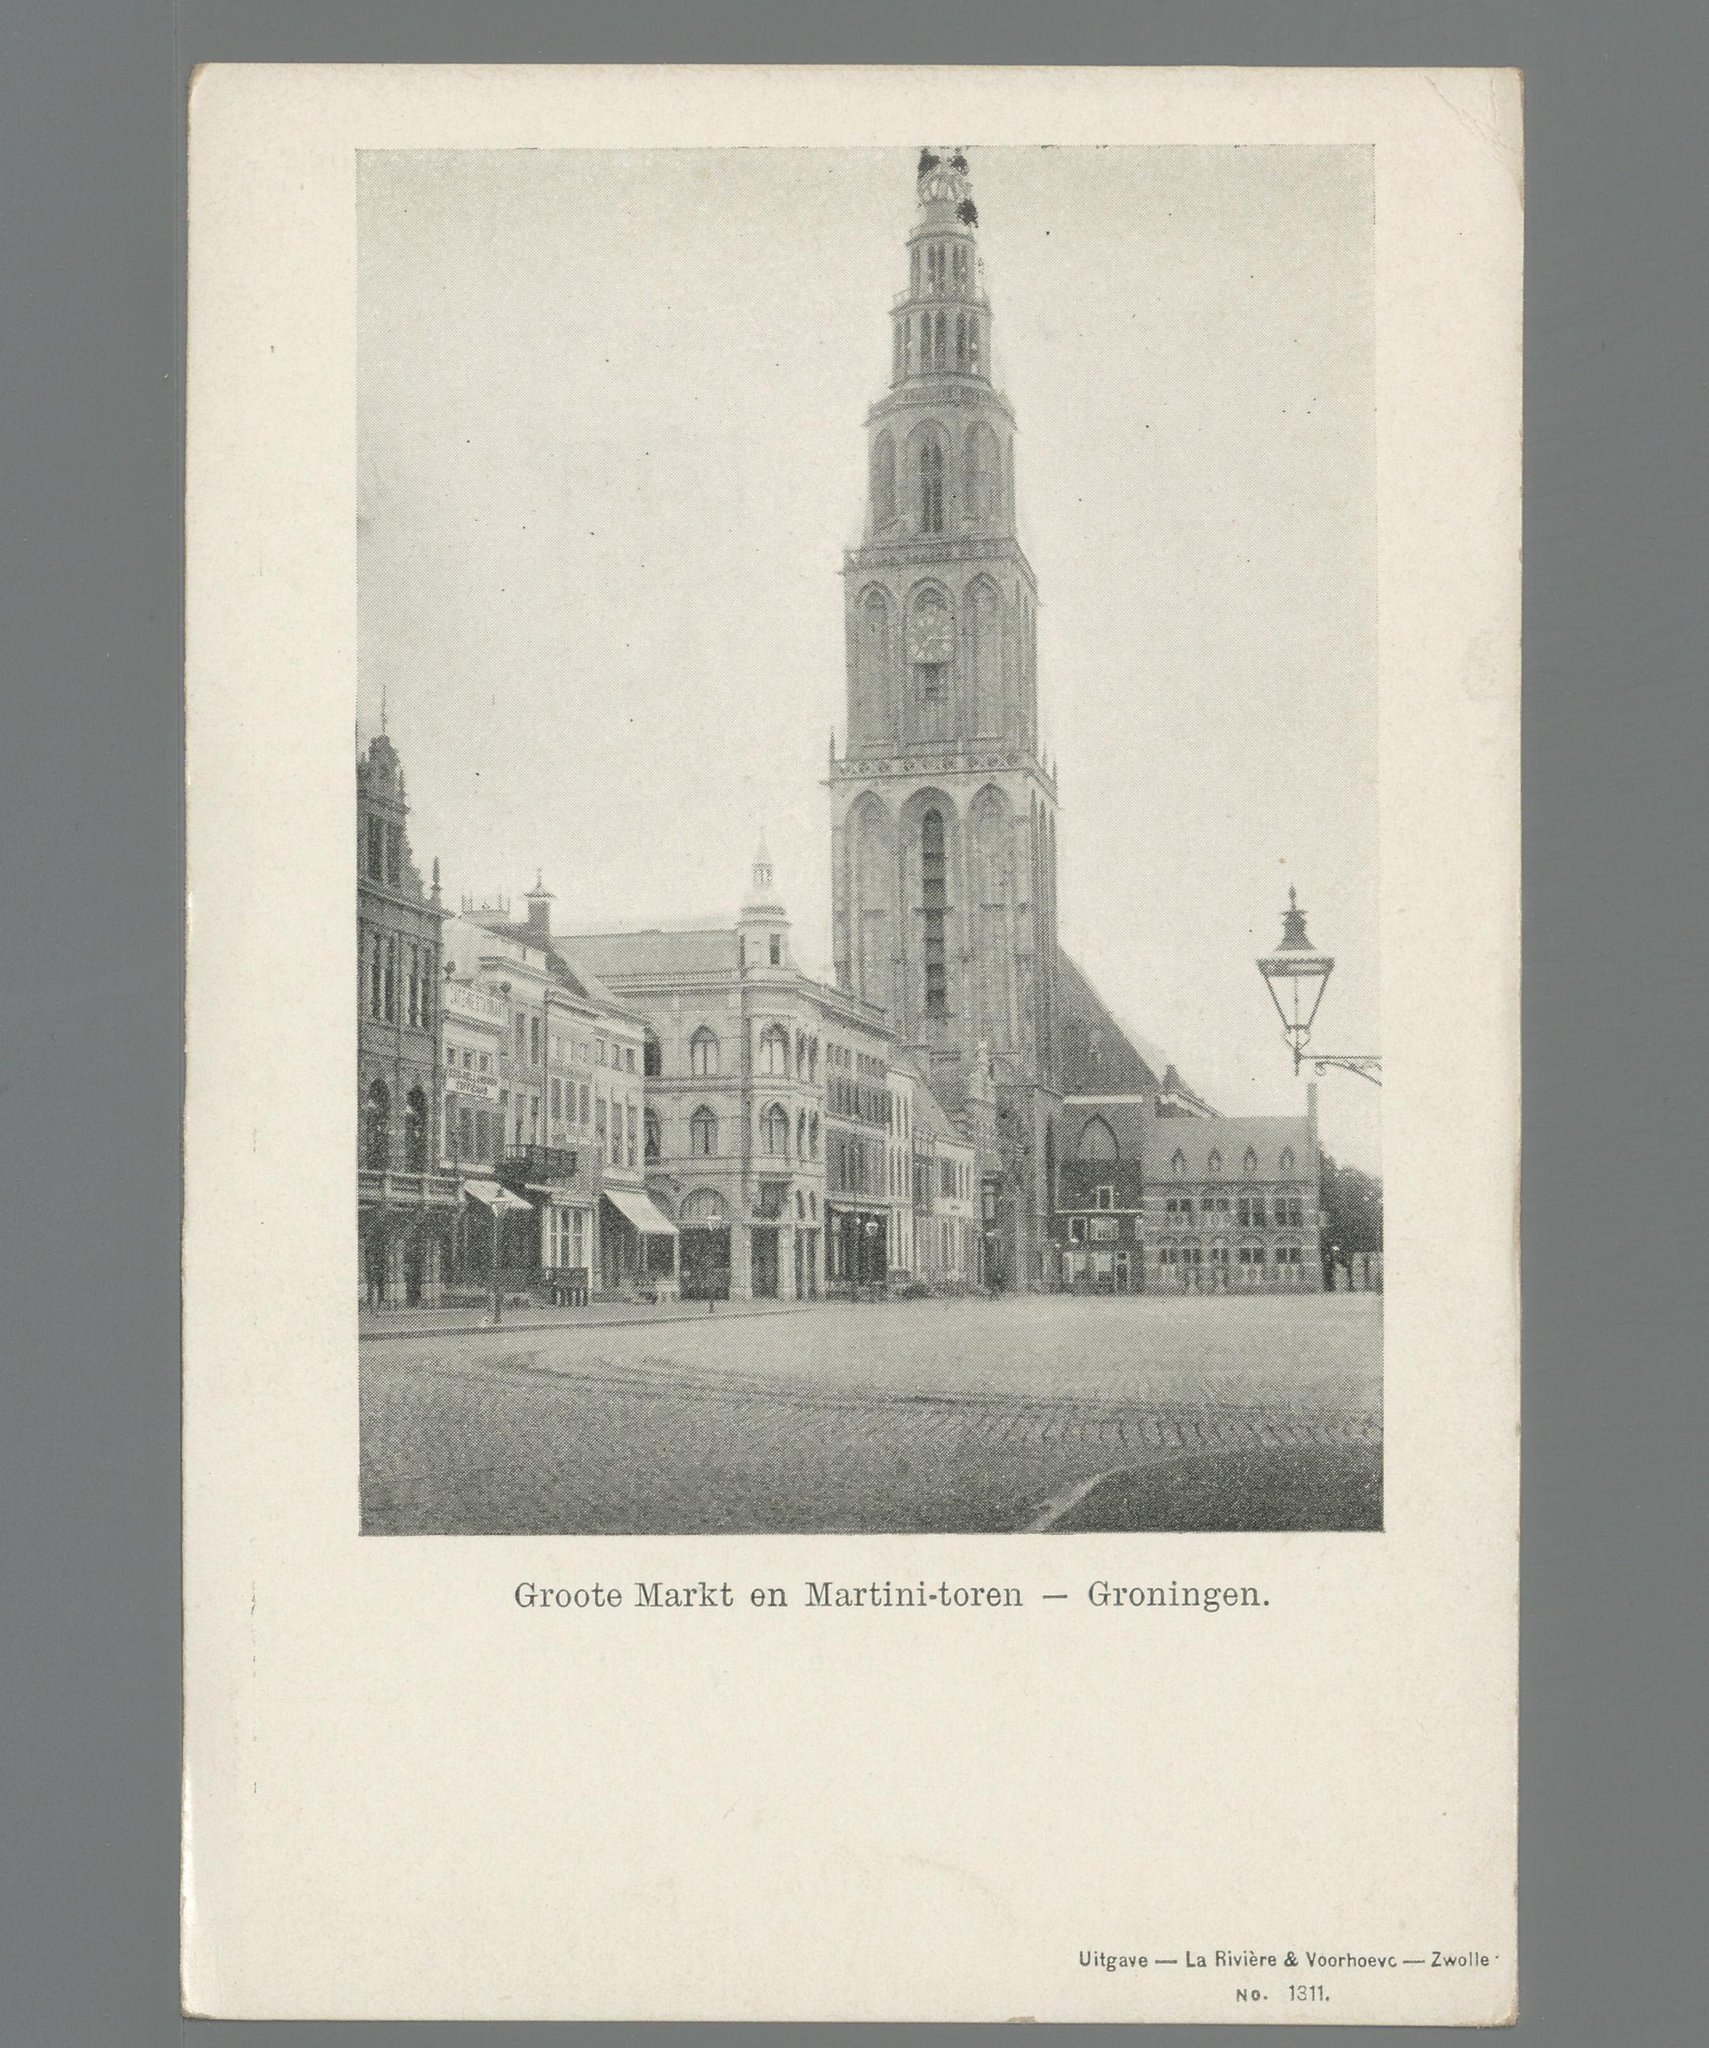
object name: photomechanical print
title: Groote Markt en Martini-toren - Groningen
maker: Anonymous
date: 1892-1905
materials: cardboard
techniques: autotype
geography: groningen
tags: square, place, circus, etc., church (exterior)